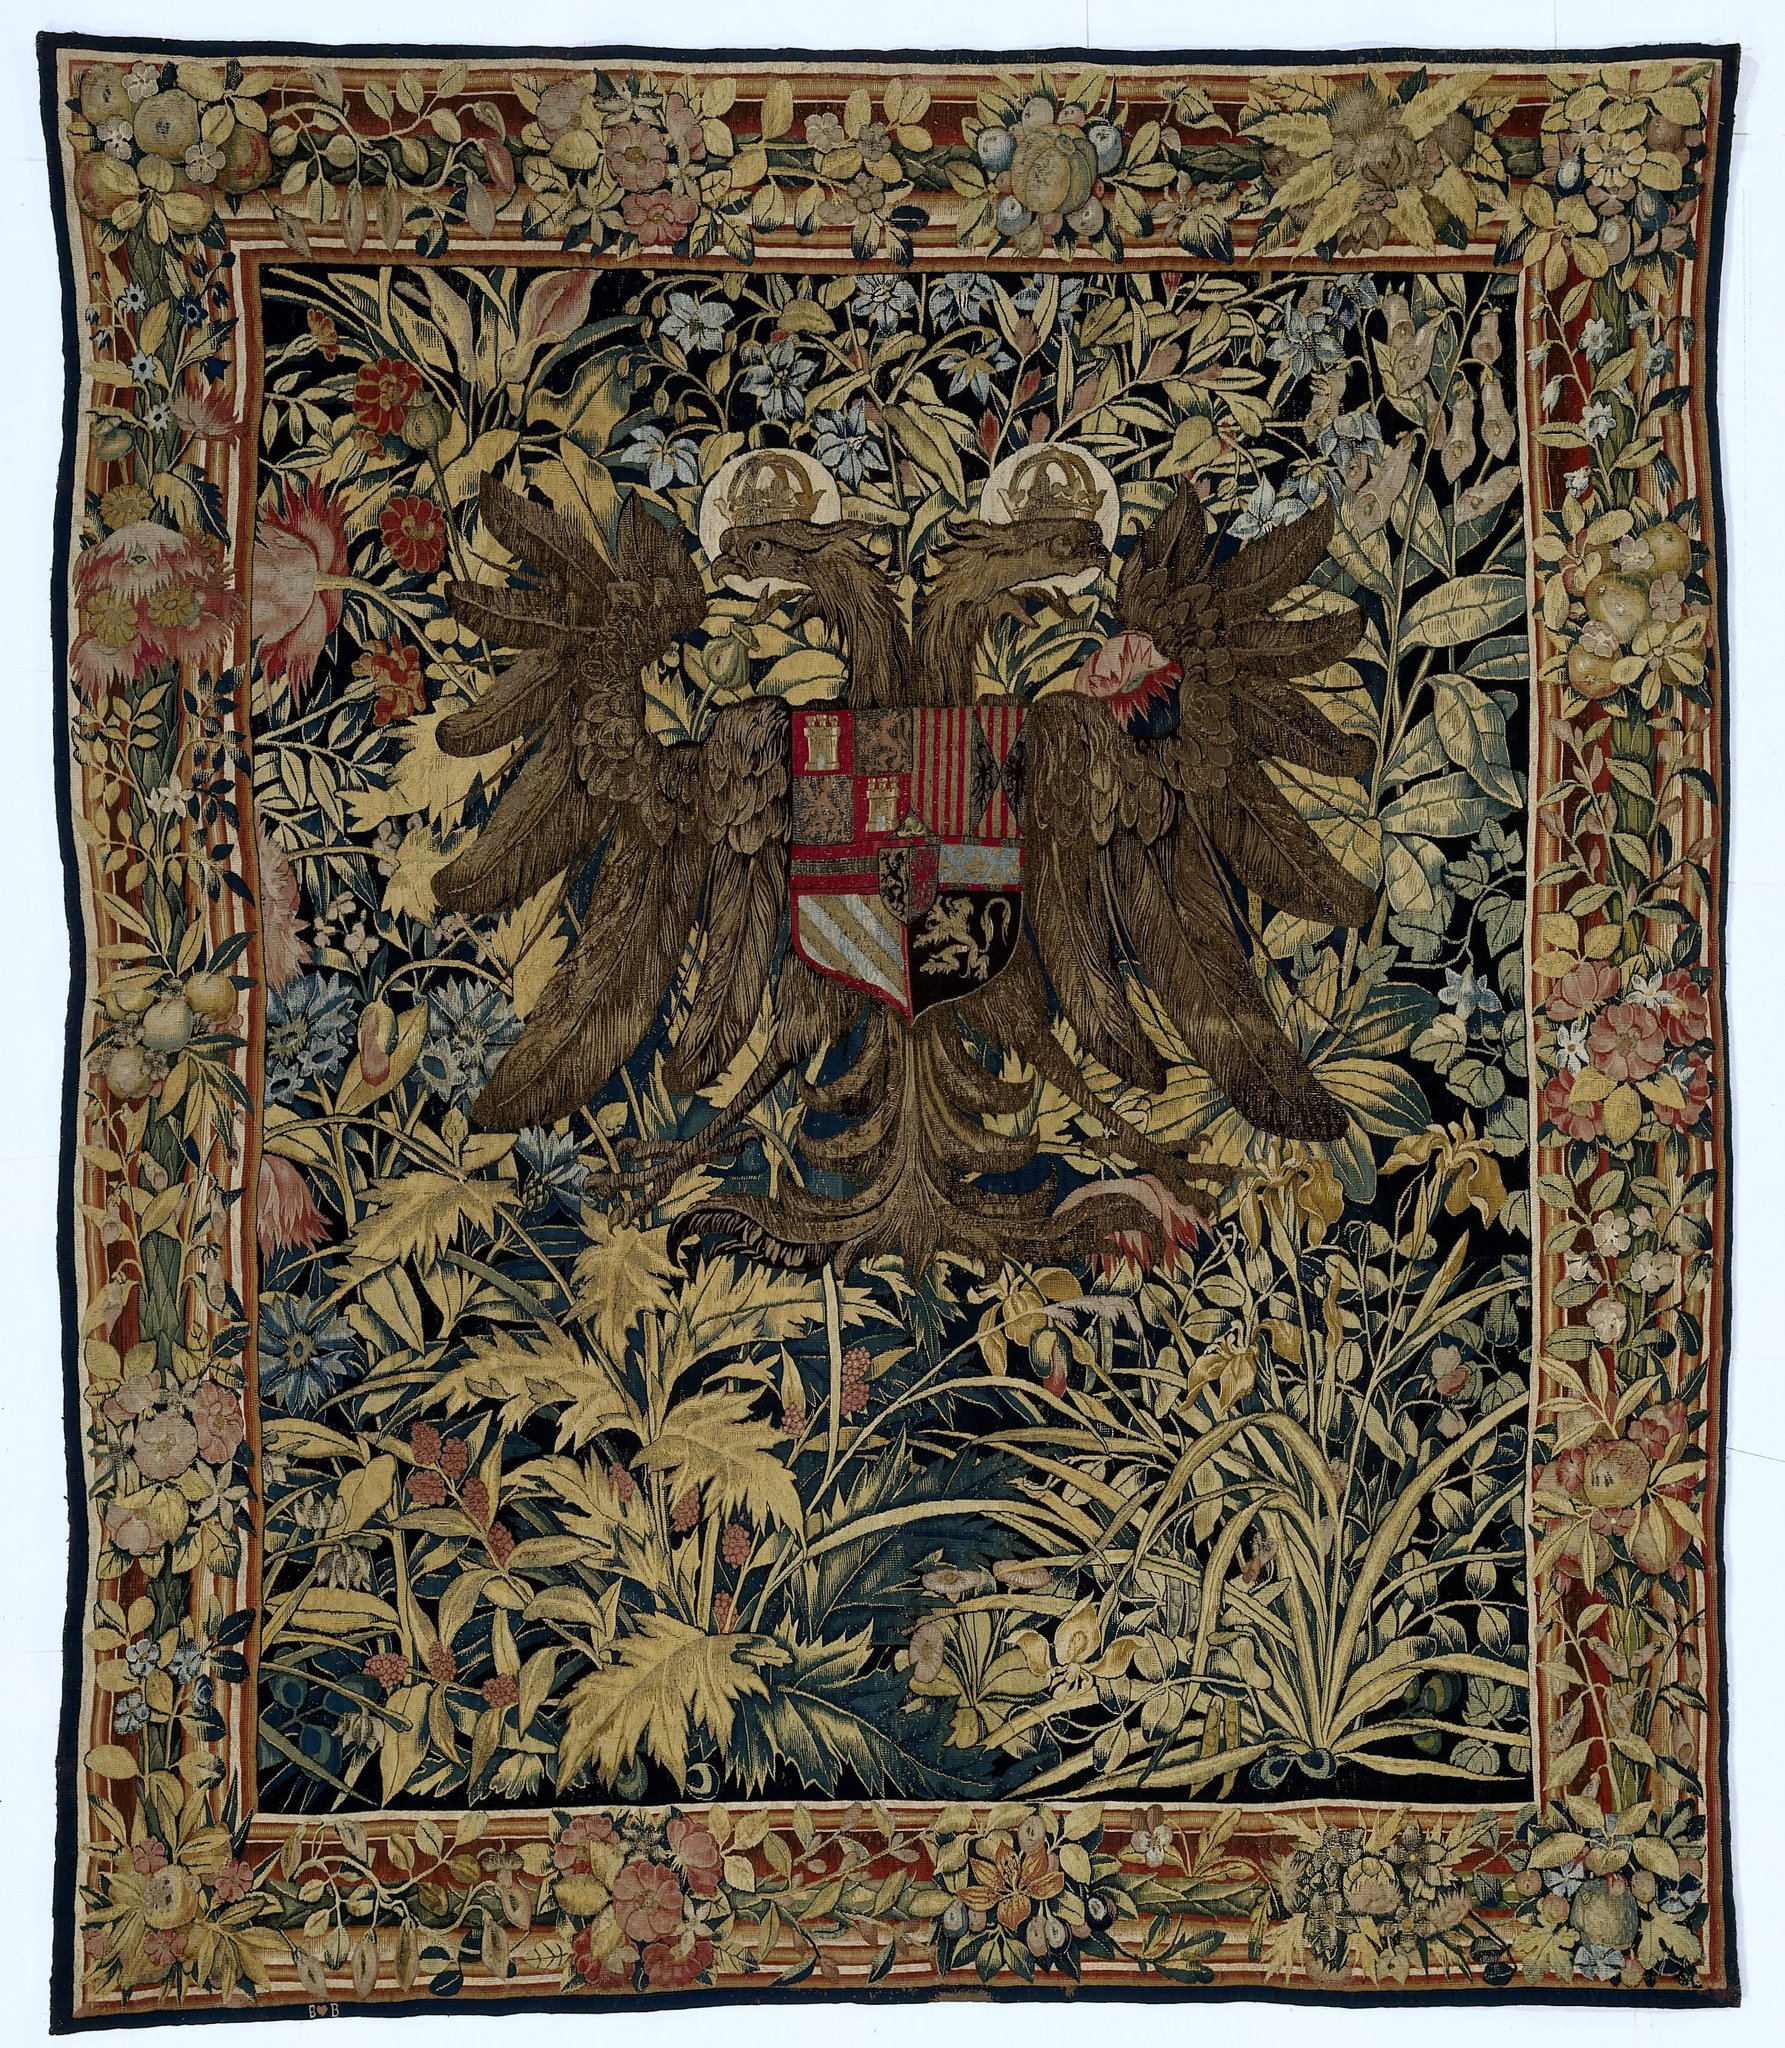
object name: tapestry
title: Tapestry with the arms of Emperor Charles V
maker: willem de pannemaker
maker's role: tapijtwever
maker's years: 1512-1581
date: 1540-1555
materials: gold thread, silk, thread, wool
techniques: tapestry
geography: brussels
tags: ghent, charles v (holy roman emperor and king of spain), flowers, coat of arms (symbol of sovereignty), plants; vegetation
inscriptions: mark: ‘BB, waartussen een hart’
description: This tapestry symbolizes the power of the Habsburg Emperor Charles V. Surrounded by abundant plants and flowers, a crowned double-headed eagle bears his coat of arms. Charles was ruler, among others, of Austria, Hungary, Sicily, Spain, Burgundy, and the Low Countries. Until his abdication in 1555, he was the most powerful man in Europe. Such tapestries were probably used on festive occasions.